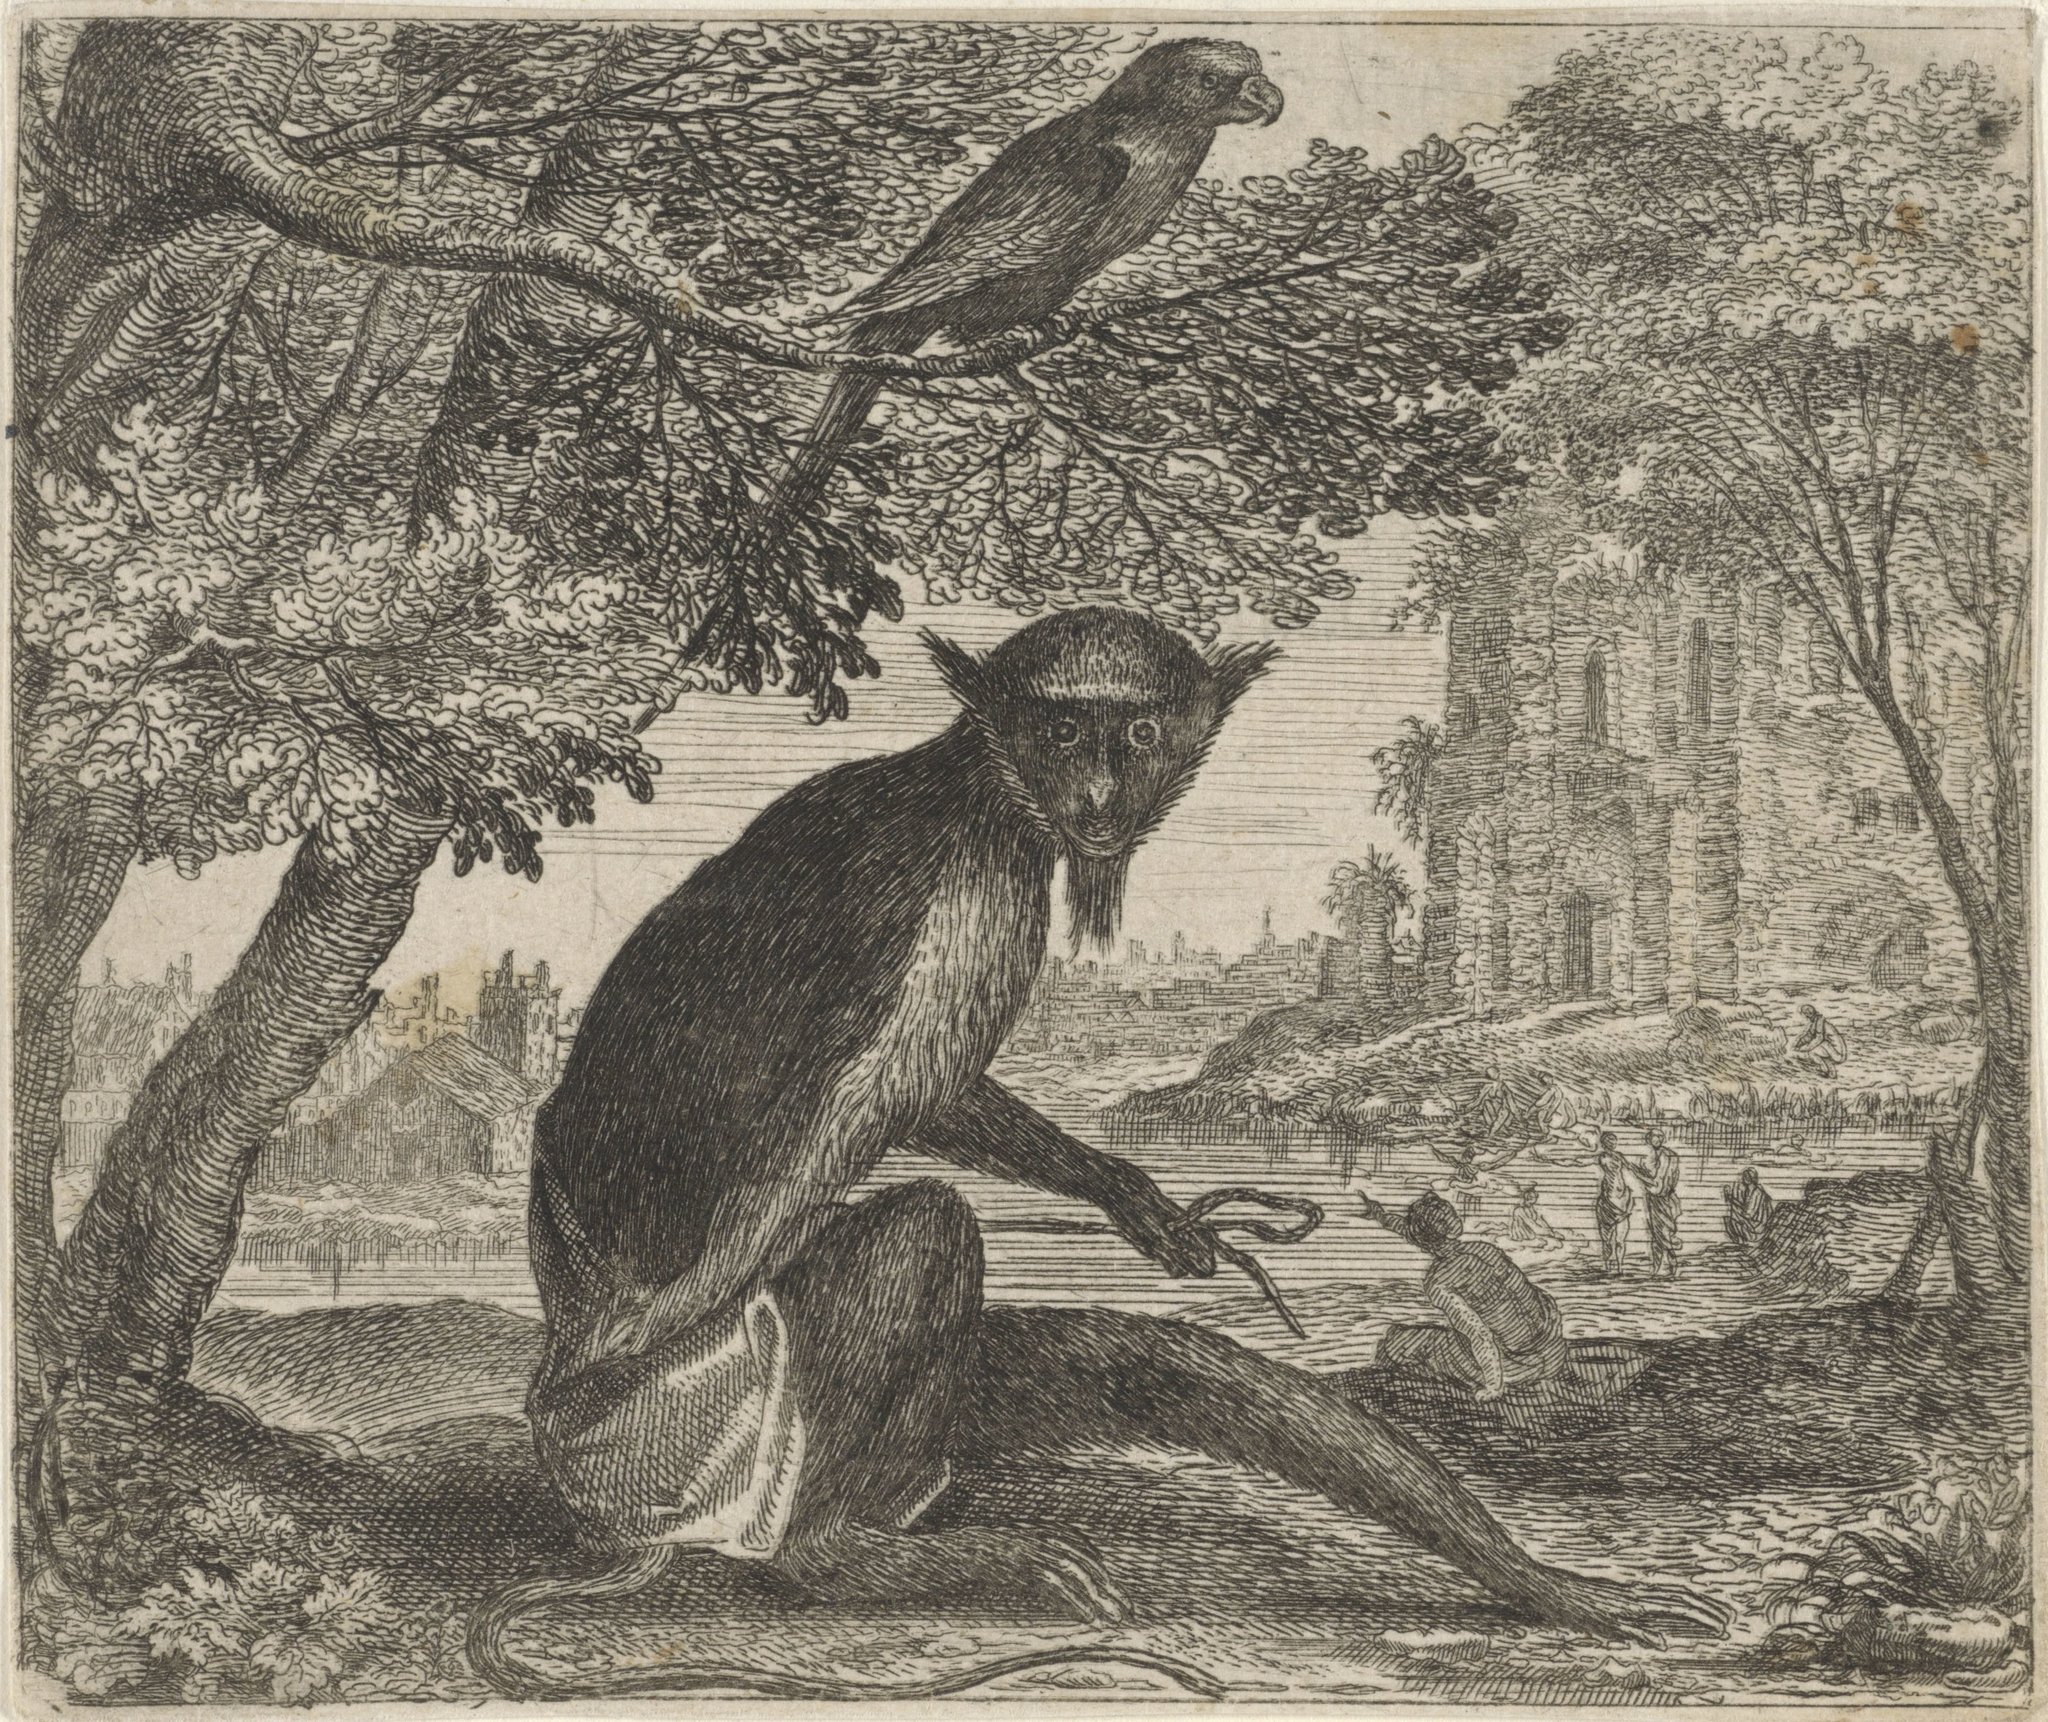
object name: book illustration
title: Fabel van de papegaai en de aap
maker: aegidius sadeler (ii)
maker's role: draughtsman, print maker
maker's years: 1568-1629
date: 1608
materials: paper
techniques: engraving, etching, letterpress printing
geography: prague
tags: monkeys, apes, ornamental birds: parrot, fables, taking a bath - aa - in the open air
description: Een papegaai zit op een tak in een boom. Onder de tak een meerkat. Op de achtergrond badende mensen bij een ruïne. De moraal van het verhaal leert dat het beter is intelligent te zijn zoals de papegaai dan sociaal zoals de meerkat.